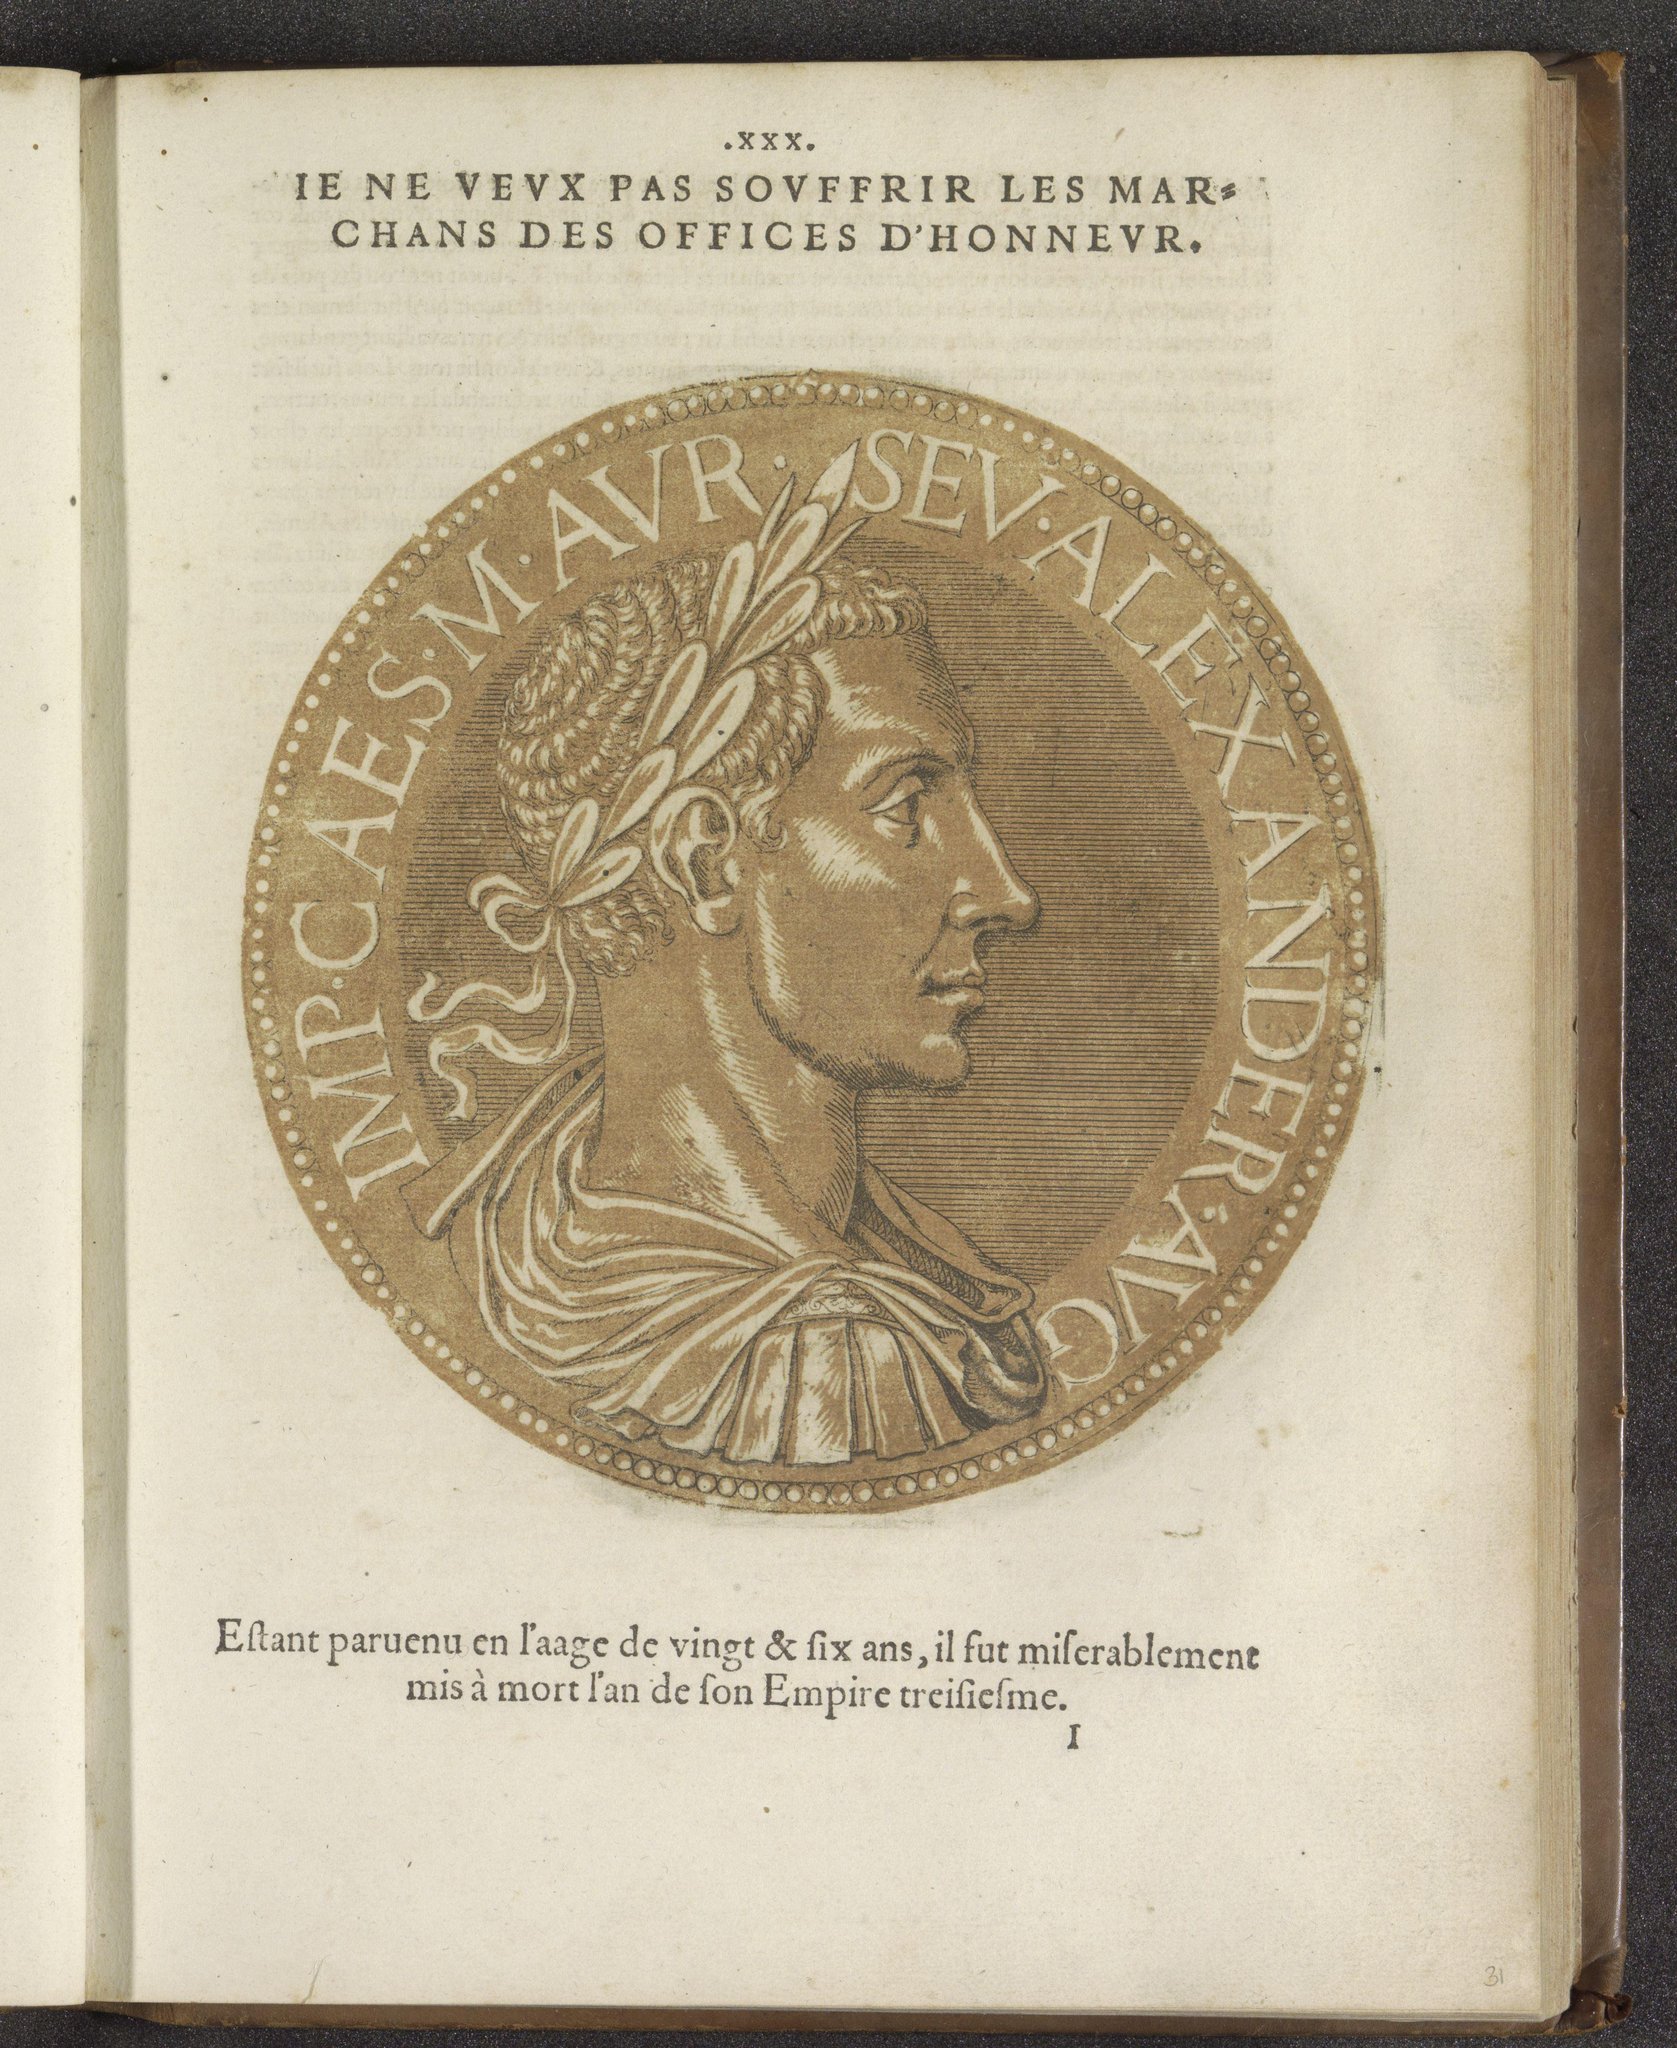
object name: print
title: Les images presque de tous les empereurs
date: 1557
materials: paper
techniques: woodcut, etching, letterpress printing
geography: antwerp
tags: emperor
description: Portret van keizer Severus Alexander, op een munt met randschrift. De prent maakt deel uit van een boek over de keizers vanaf Julius Caesar tot en met Karel V en zijn broer Ferdinand.